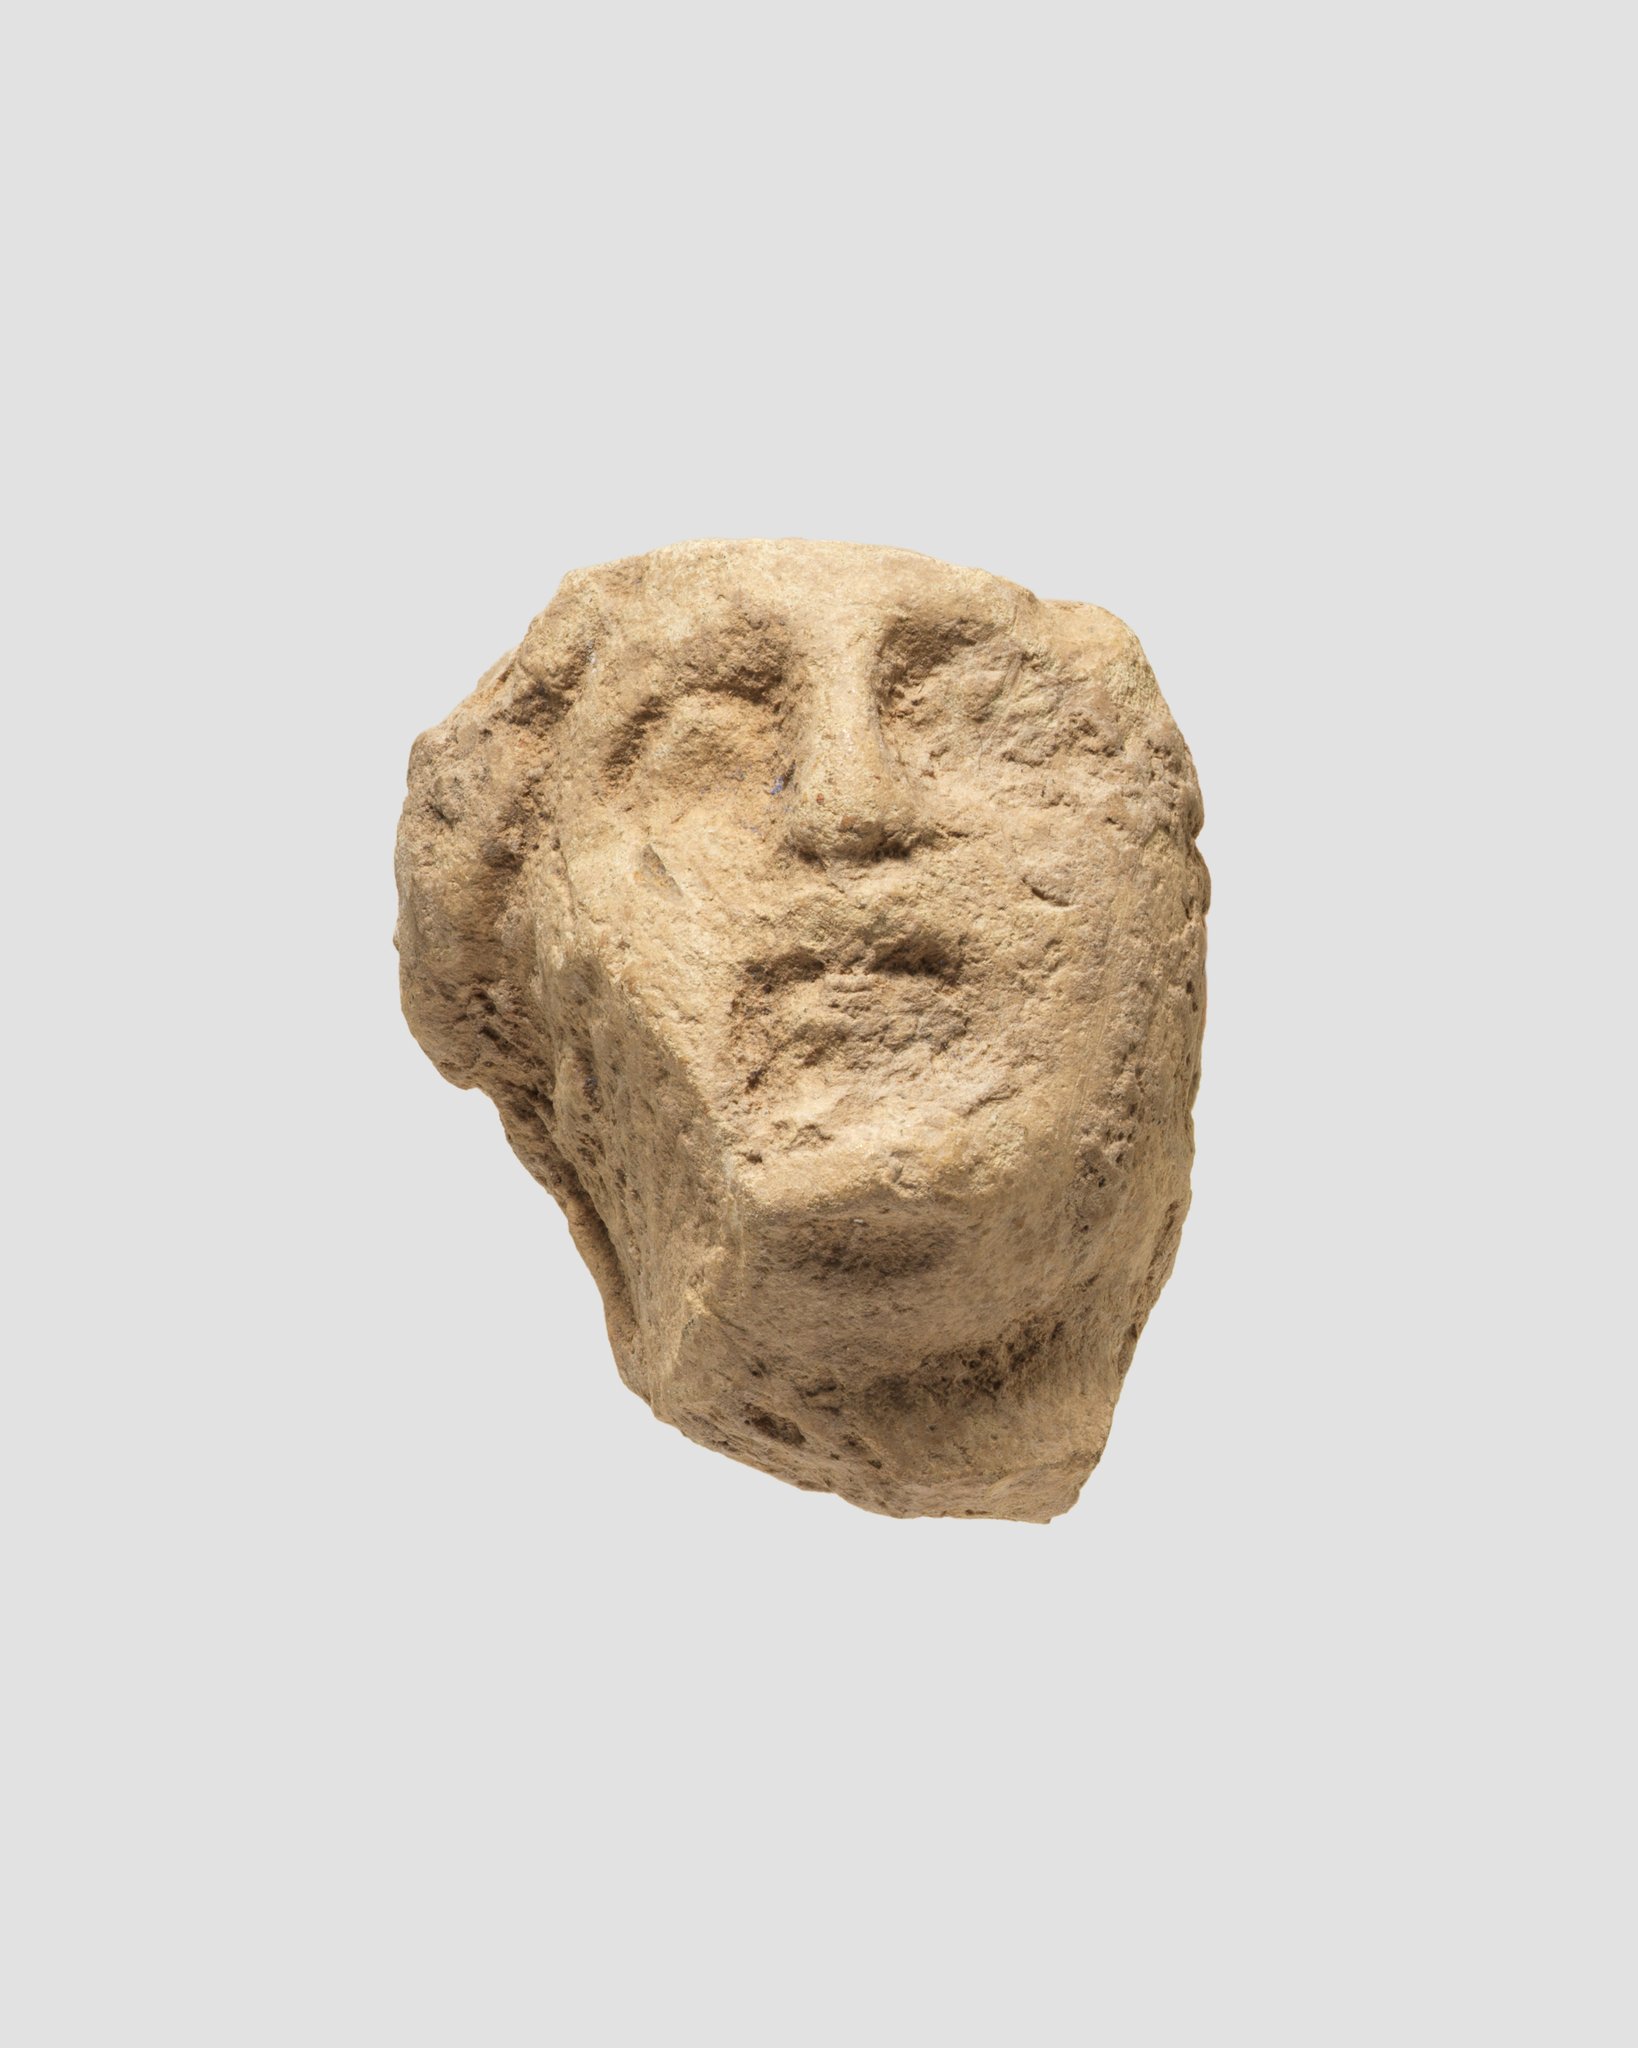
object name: sculpture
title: Fragment of head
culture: parthian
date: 101-200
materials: ceramic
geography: mesopotamia